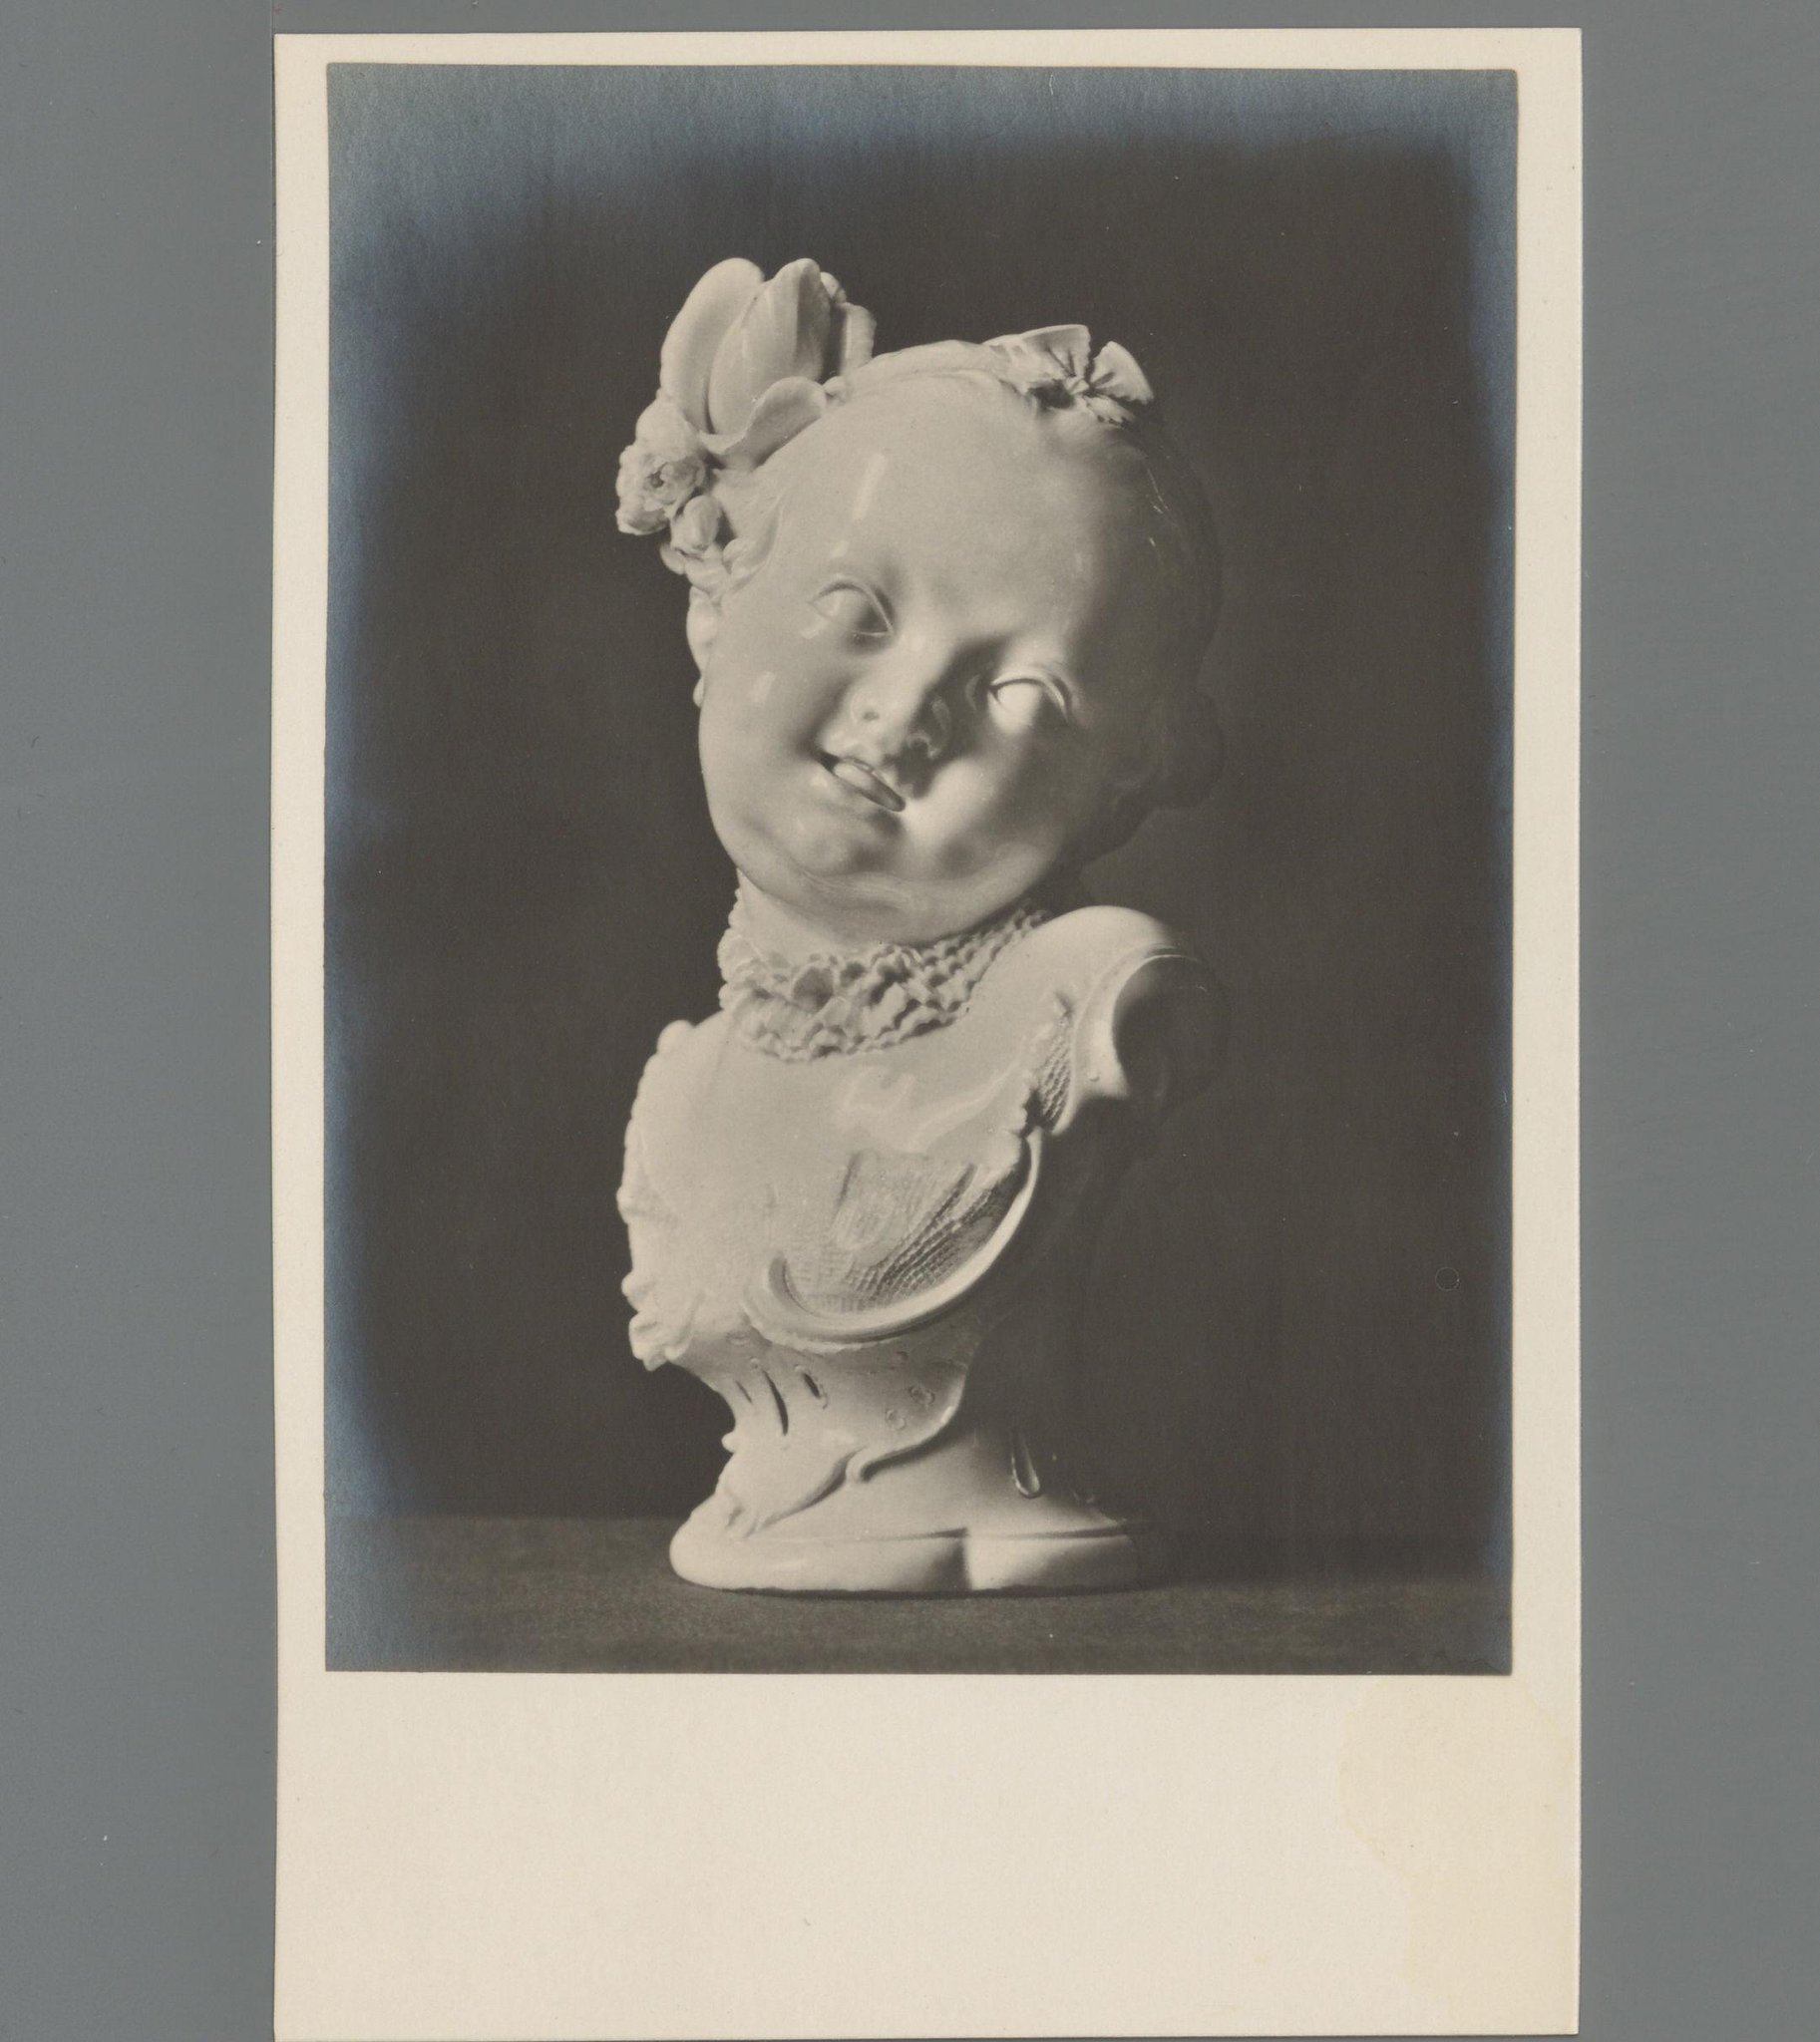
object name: ansichtkaart, prentbriefkaart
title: Schlossmuseum, Berlin. F. Bustelli; Mädchenkopf. Nymphenburger Porzellan um 1760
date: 1918-1930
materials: photographic support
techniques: photography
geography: berlin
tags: castle, statues, paintings, etc. ~ objects of worship in roman religion, permanent exhibition, museum